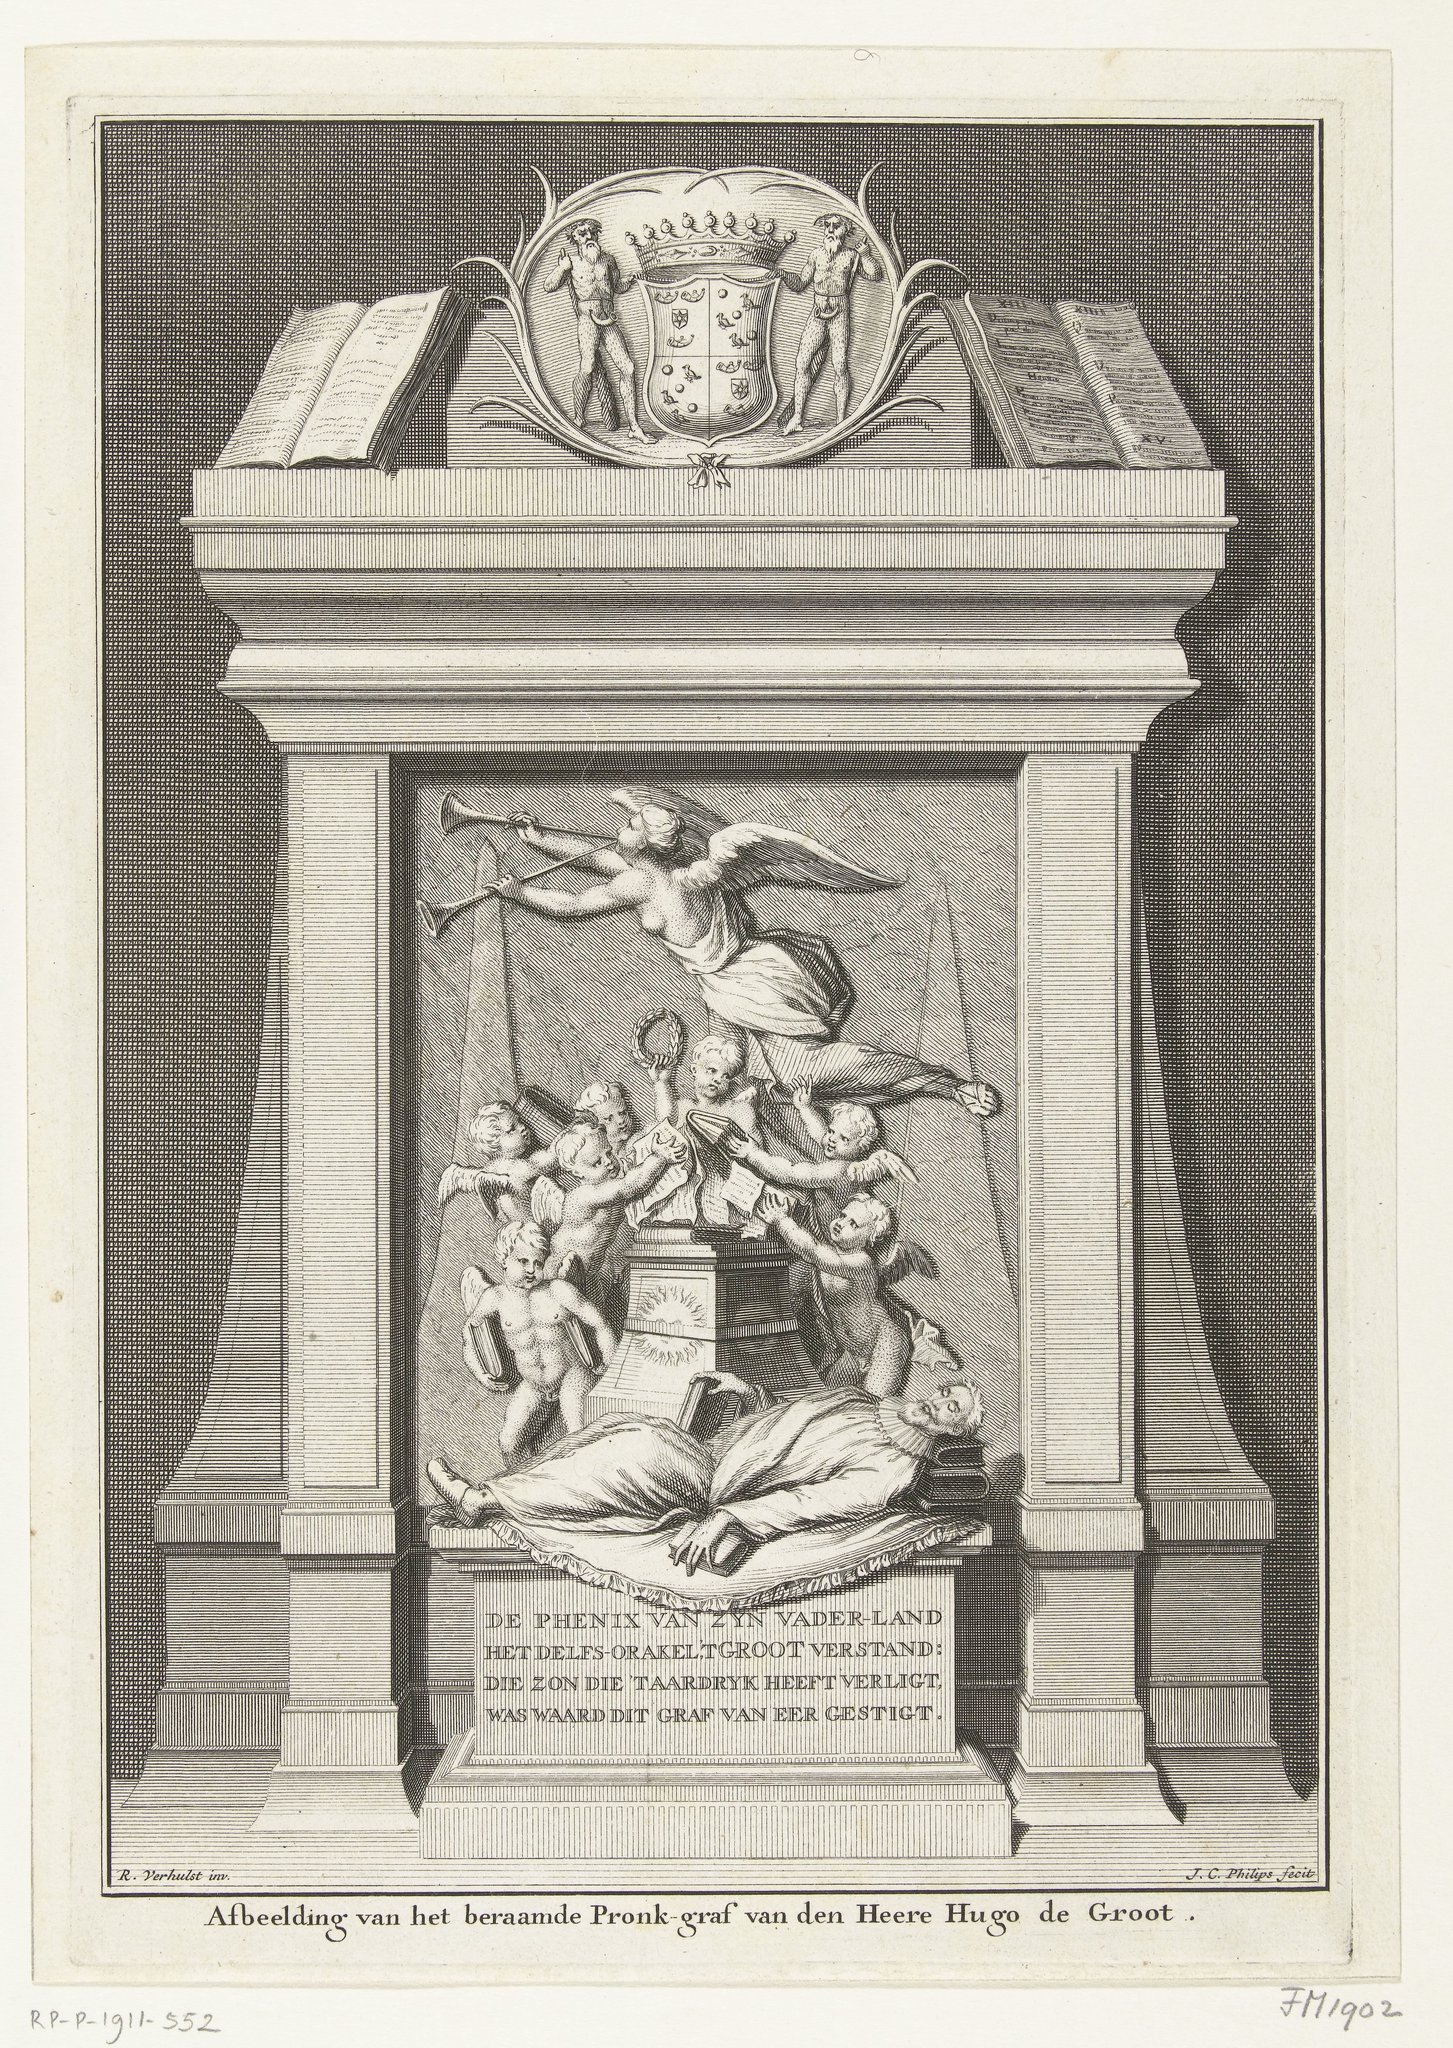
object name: historical object representation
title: Ontwerp voor de graftombe van Hugo de Groot, overleden 1645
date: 1711-1713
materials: paper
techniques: etching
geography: netherlands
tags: delft, hugo de groot, grave-building, monumental tomb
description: Gebruikt als illustratie in: Cornelis van Alkemade, Inleidinge tot het ceremonieel, en de plegtigheden der begraavenissen en der wapen-kunde, Andries Voorstad (I), Delft 1713 en in Caspar Brandt, Historie van het leven des heeren Huig de Groot, J. van Braam (Dordrecht) en G. onder de Linden (Amsterdam) 1727.